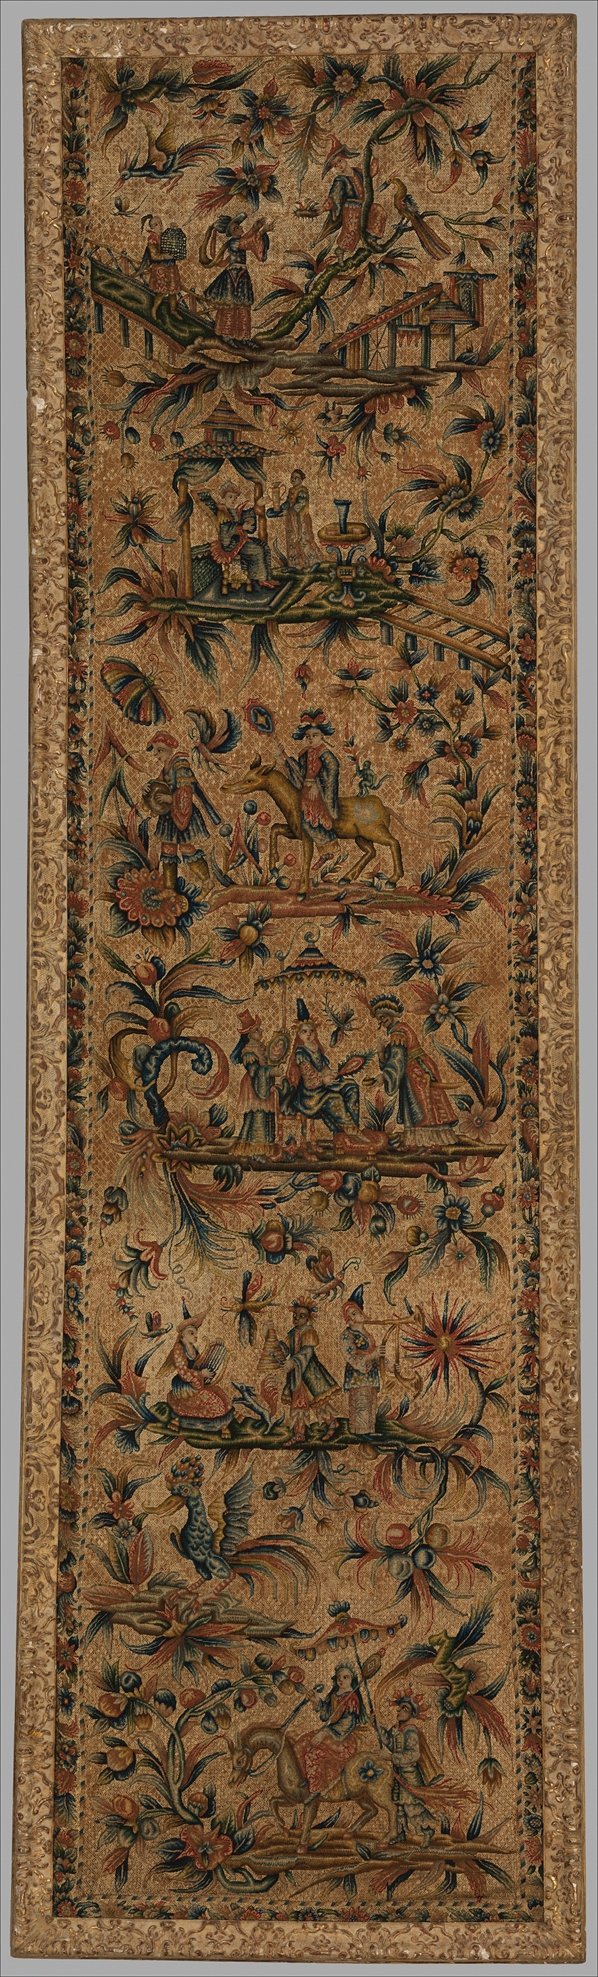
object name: panel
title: Embroidered panel with chinoiserie scenes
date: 1701-1725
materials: canvas, silk, wool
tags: birds,men,women,horses